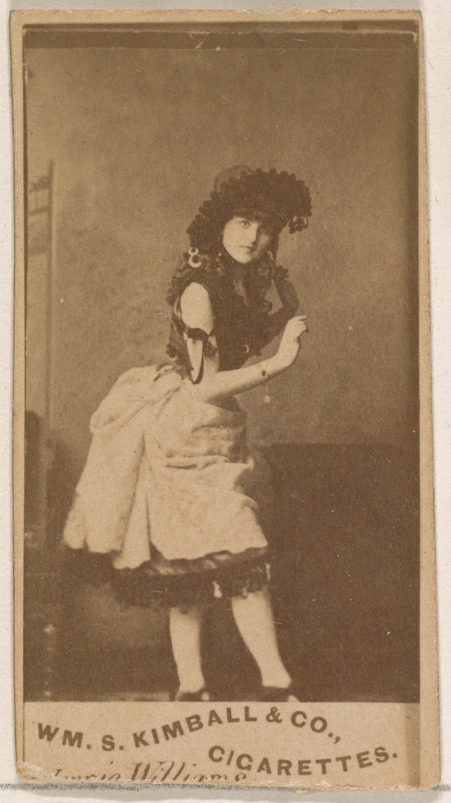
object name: photograph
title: Lucia Willimme, from the Actresses series (N203) issued by Wm. S. Kimball & Co.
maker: william s. kimball & company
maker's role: publisher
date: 1889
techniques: color lithograph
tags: portraits,women,actresses